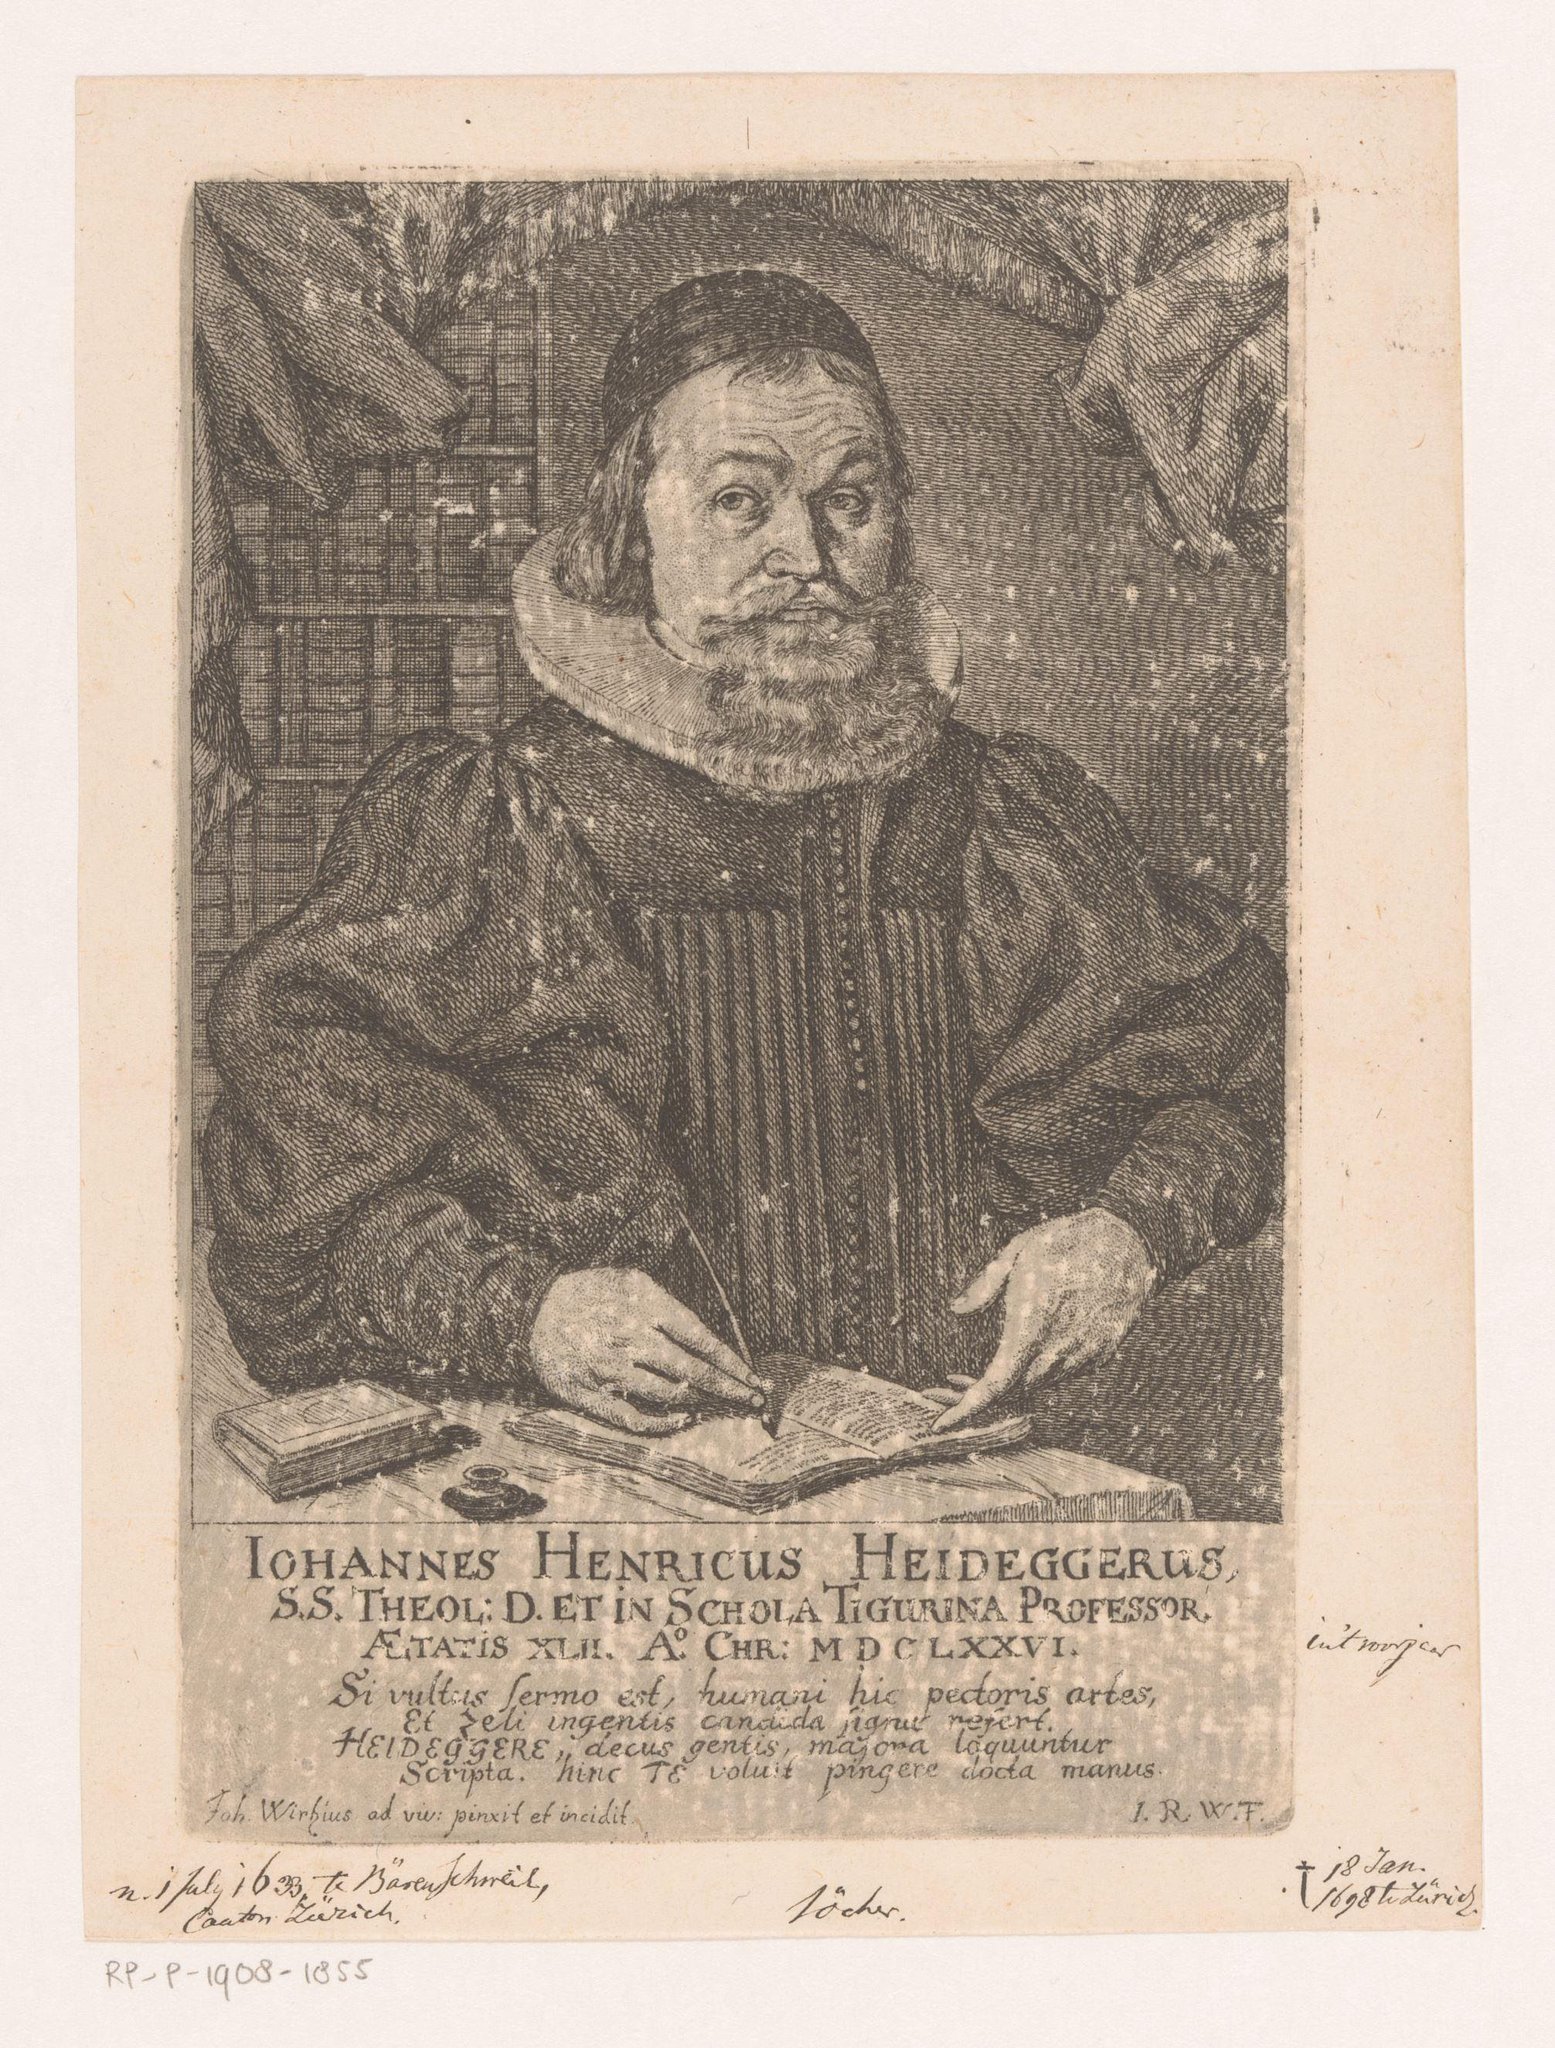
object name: print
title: Portret van Johann Heinrich Heidegger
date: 1676-1710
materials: paper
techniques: engraving, etching, intaglio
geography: switzerland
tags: switzerland, historical persons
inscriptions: inscription: ‘in 't voorjaar’, collector's mark: Lugt 2228, inscription: ‘n. 1 July 1633 te Bärenschweil, Canton Zürich. / [...] / 18 Jan. 1698 te Zürich.’